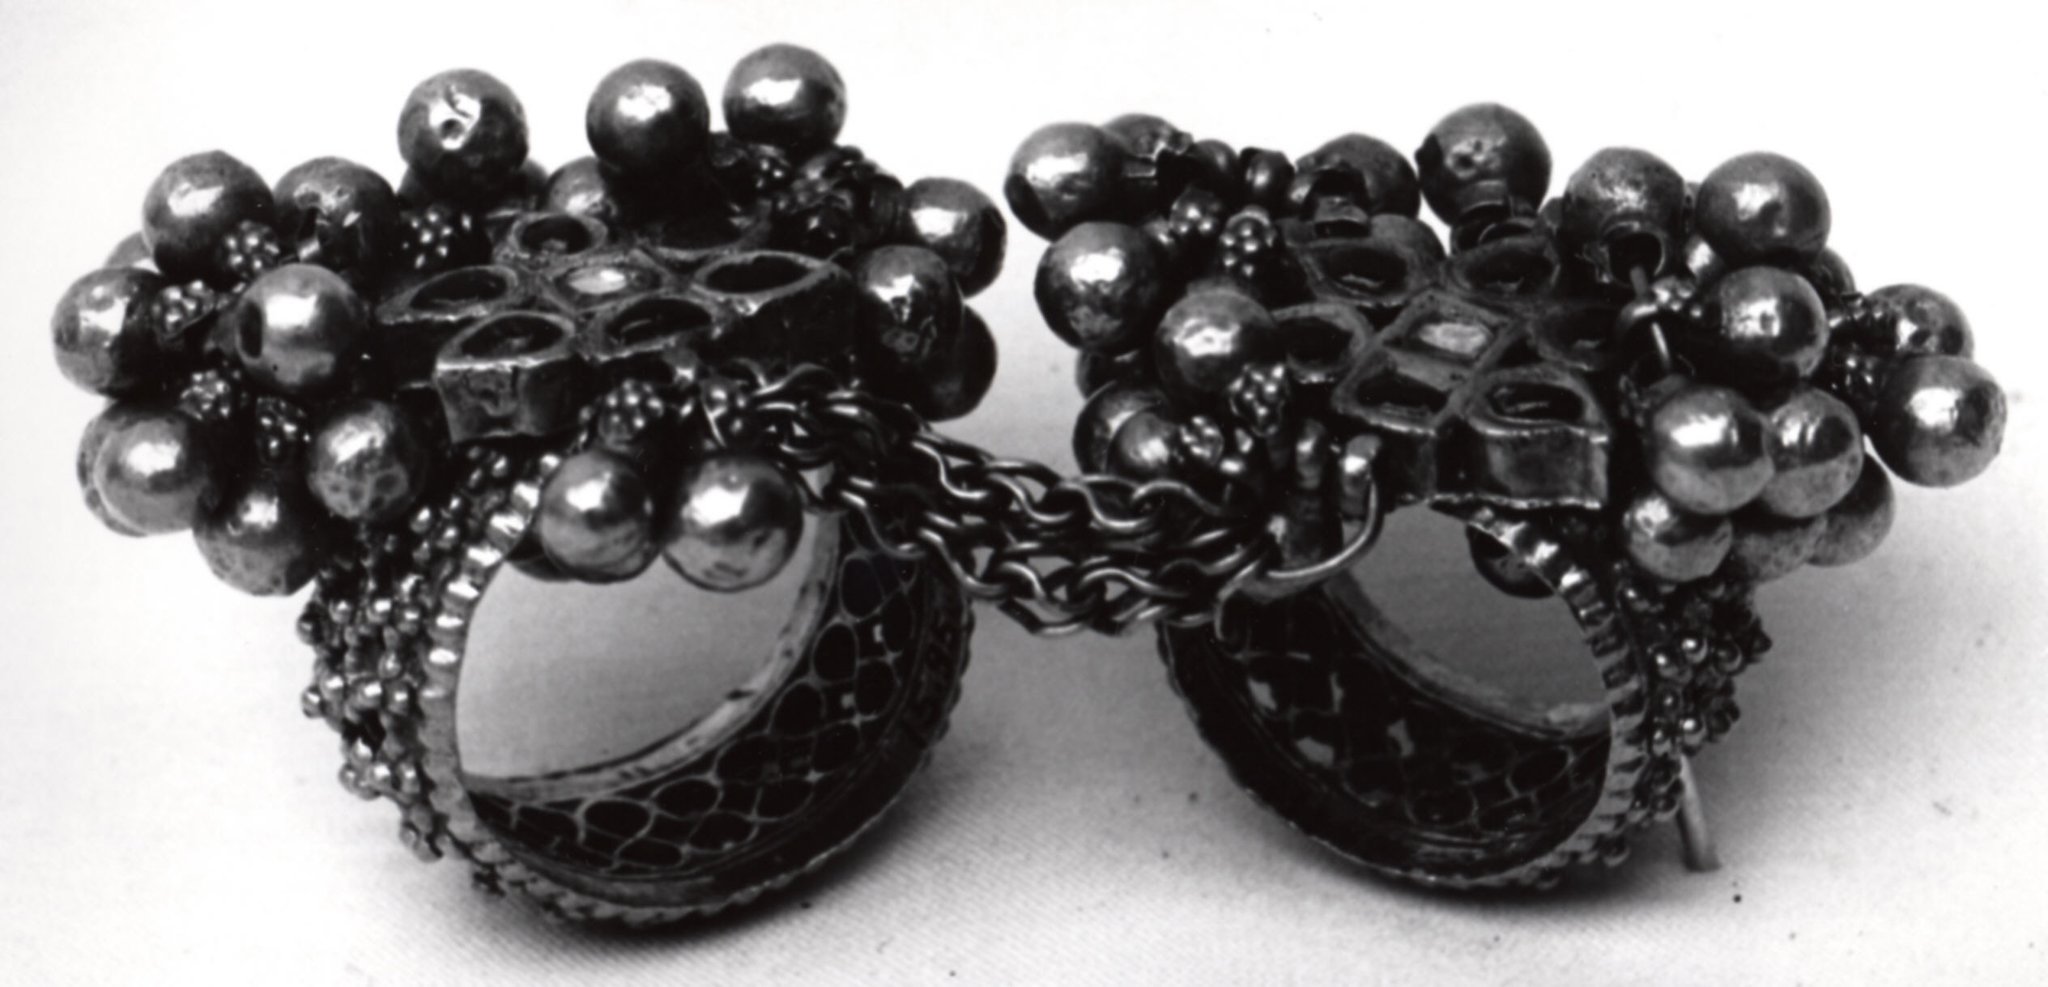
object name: ring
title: Ring, One of a Pair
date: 1701-1900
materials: gold, gemstone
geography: northern india